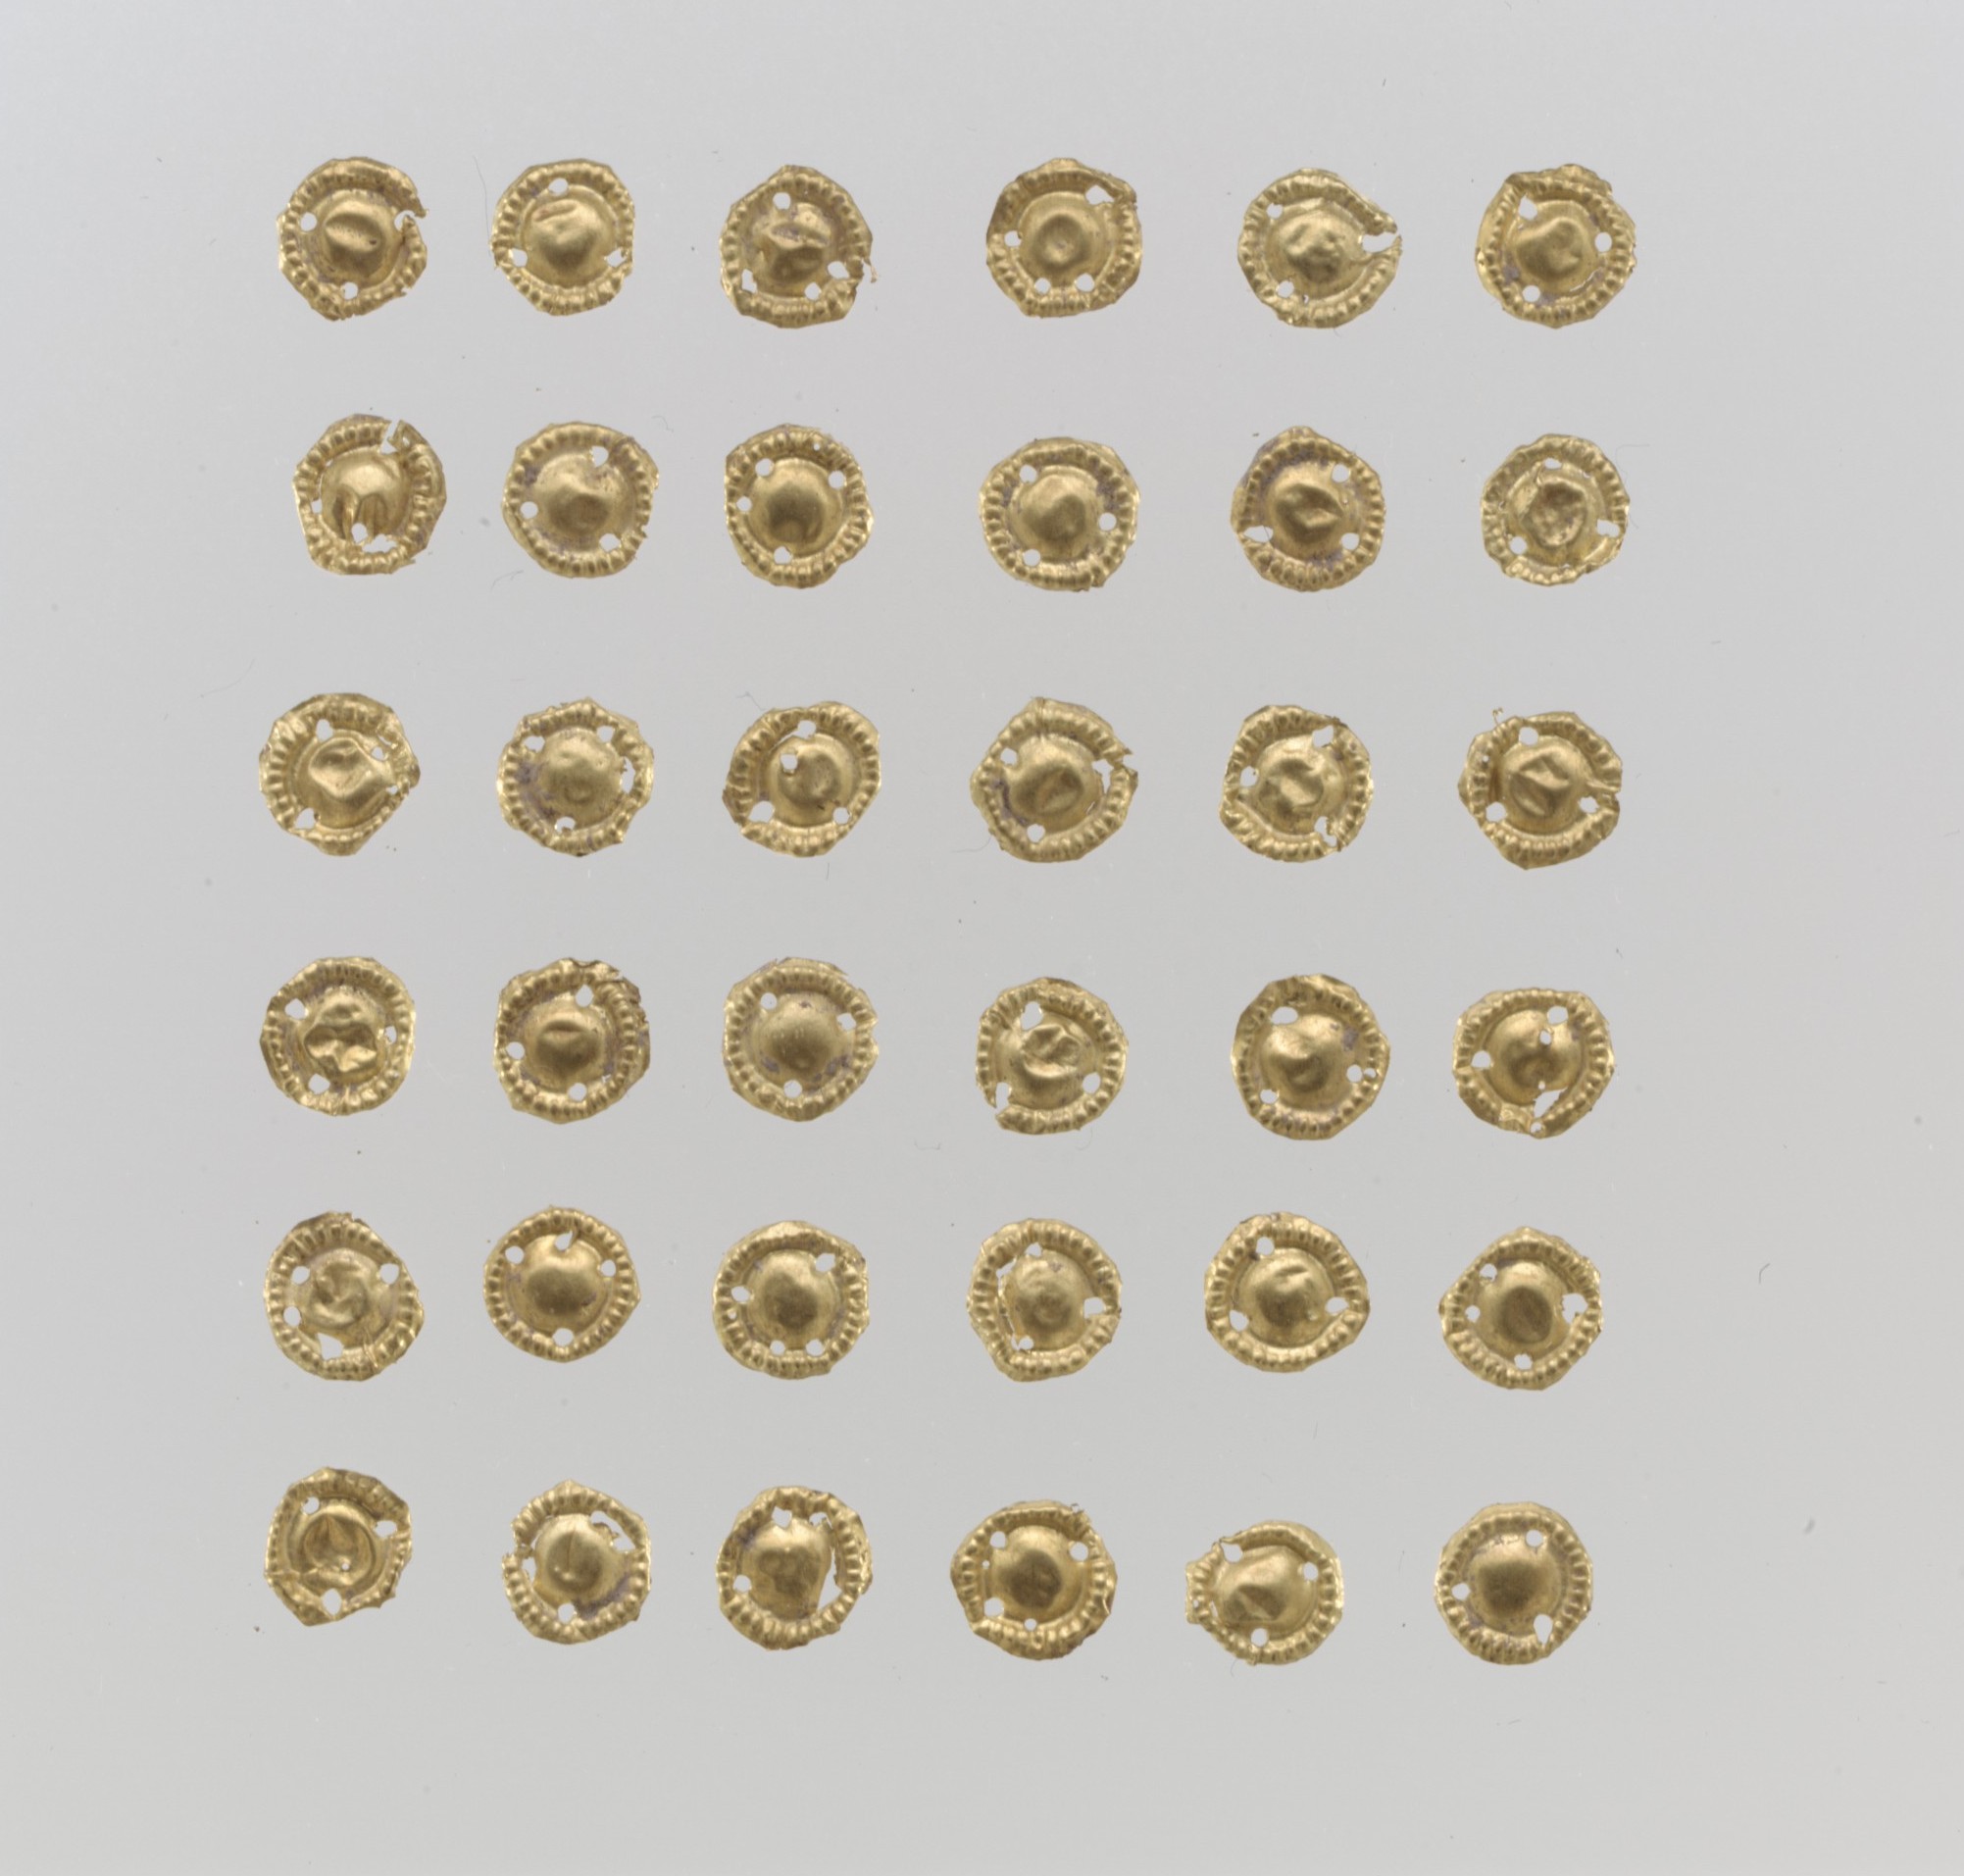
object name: sheet applique, circular, 120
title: Sheet appliques, circular, 120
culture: east germanic or nomadic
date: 401-450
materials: gold